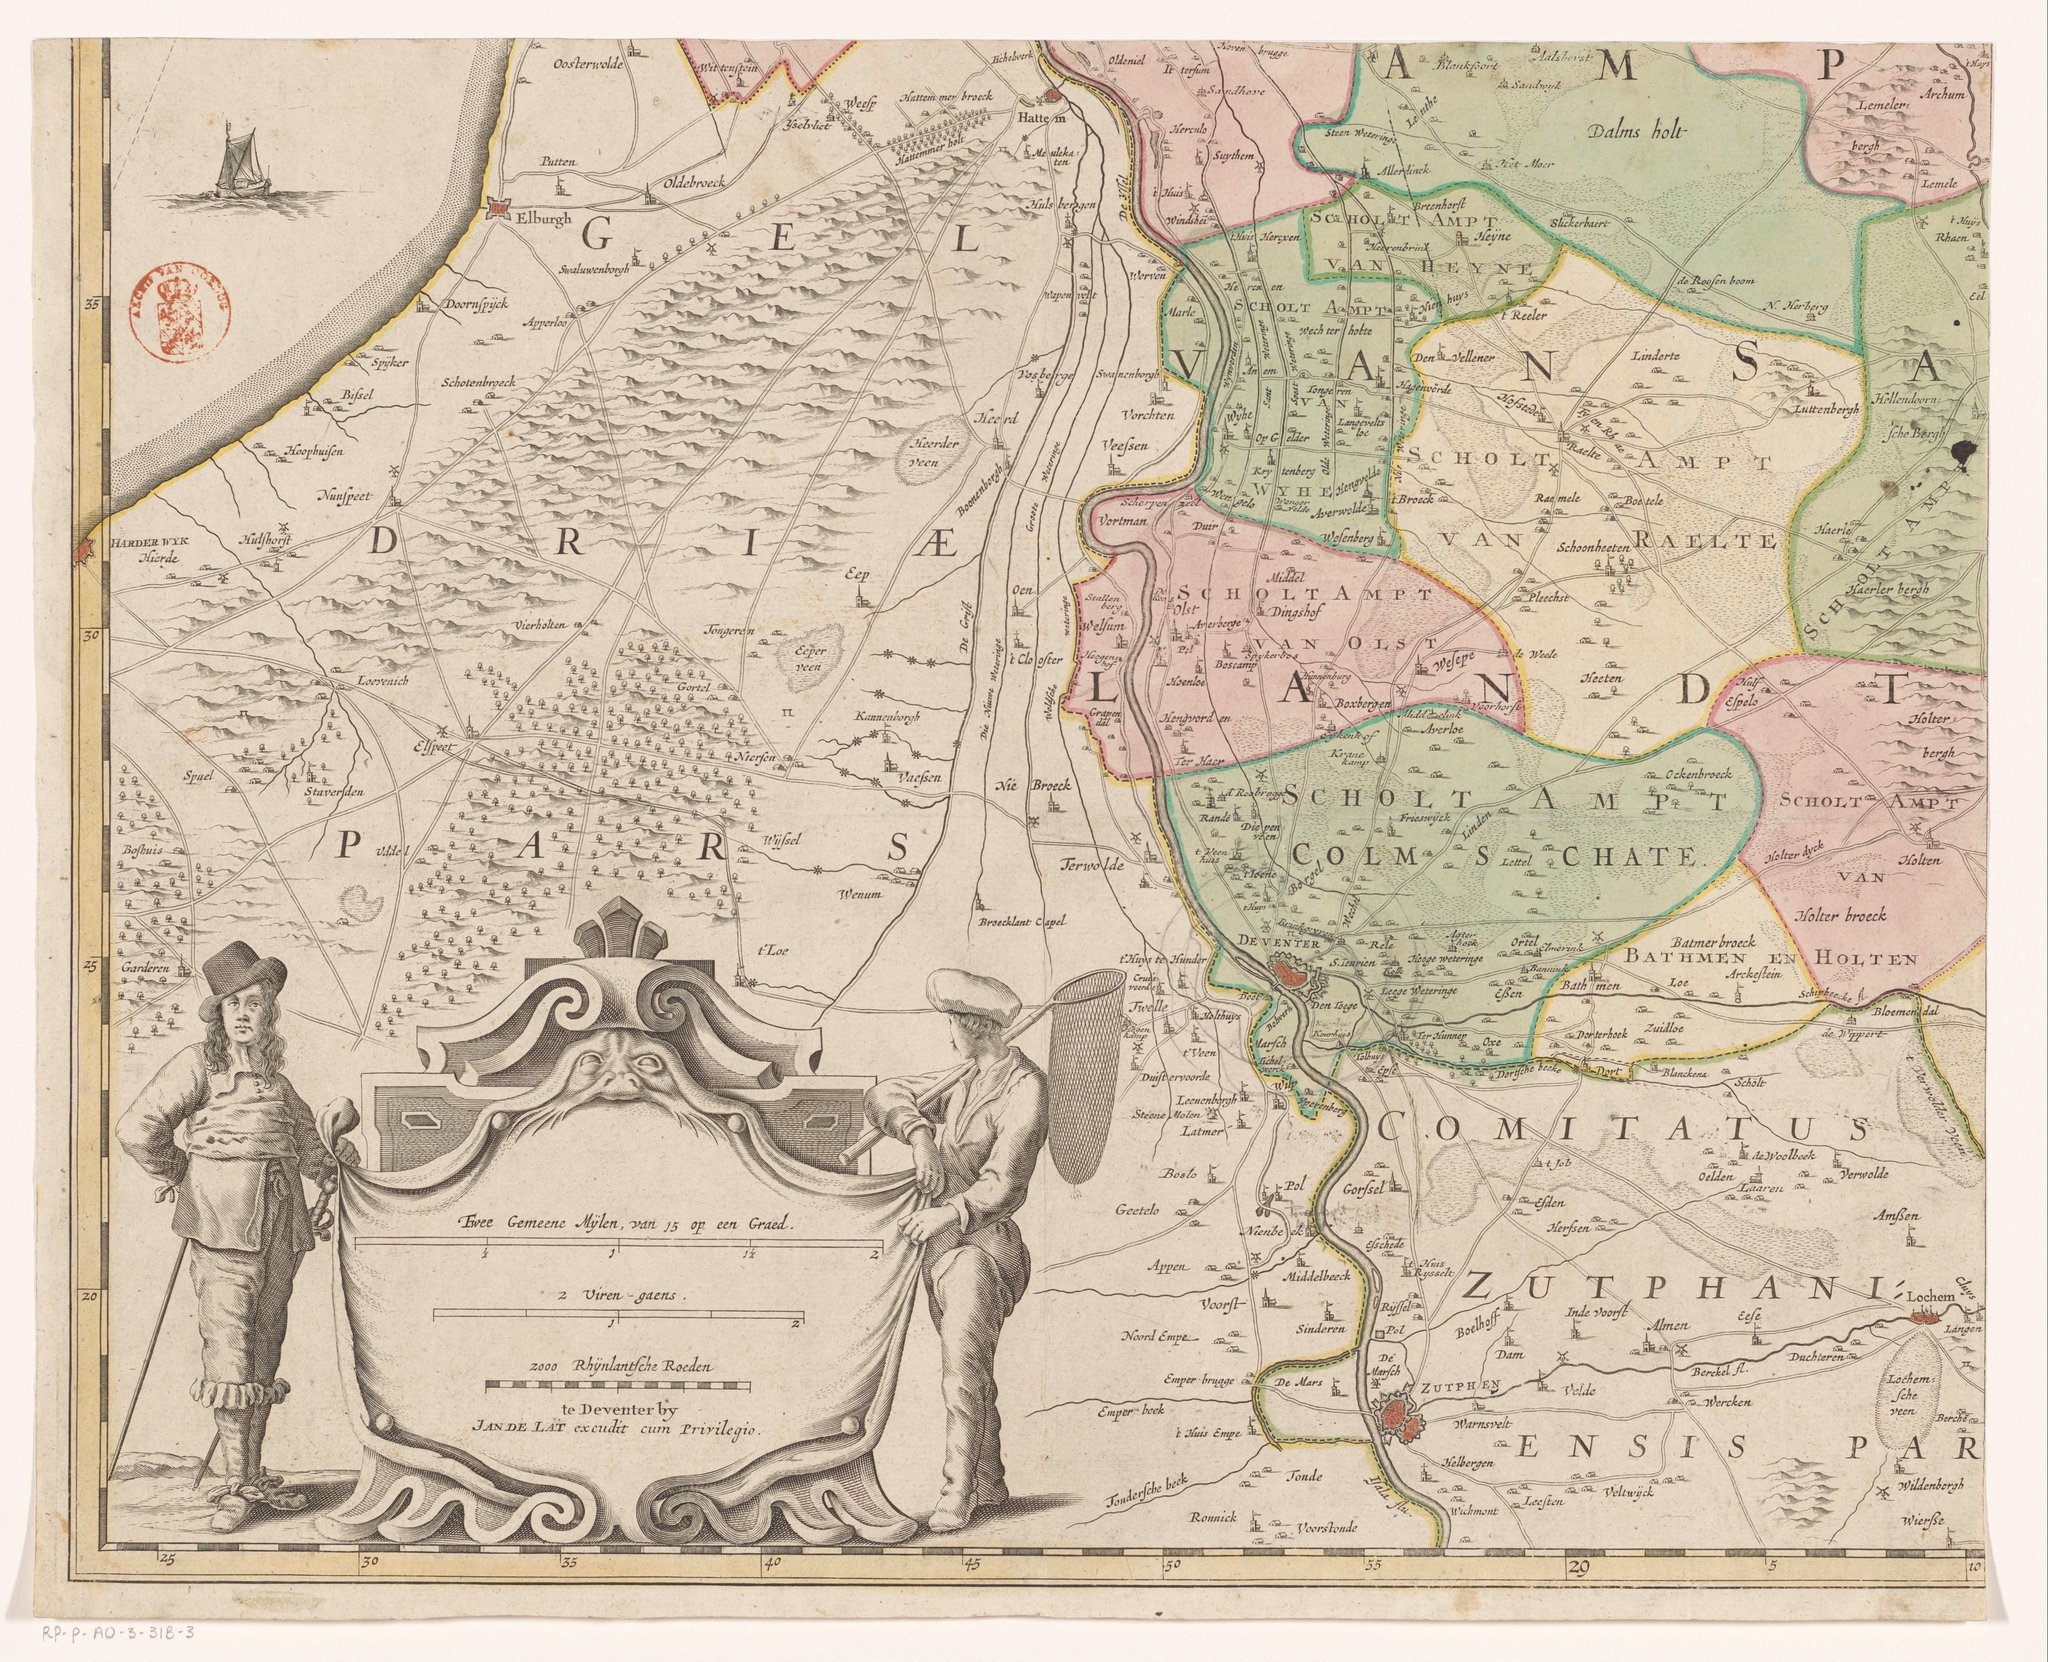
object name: map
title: Kaart van Overijssel (deel linksonder)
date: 1743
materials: paper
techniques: engraving, hand coloring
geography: deventer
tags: maps of separate countries or regions, fisherman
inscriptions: collector's mark: Lugt 19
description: Prent ook gebruikt in: Nieuwe atlas inhoudende de vier gedeeltens der waereld (...). 5 delen. Amsterdam: Covens & Mortier, s.a. [1721-1759].